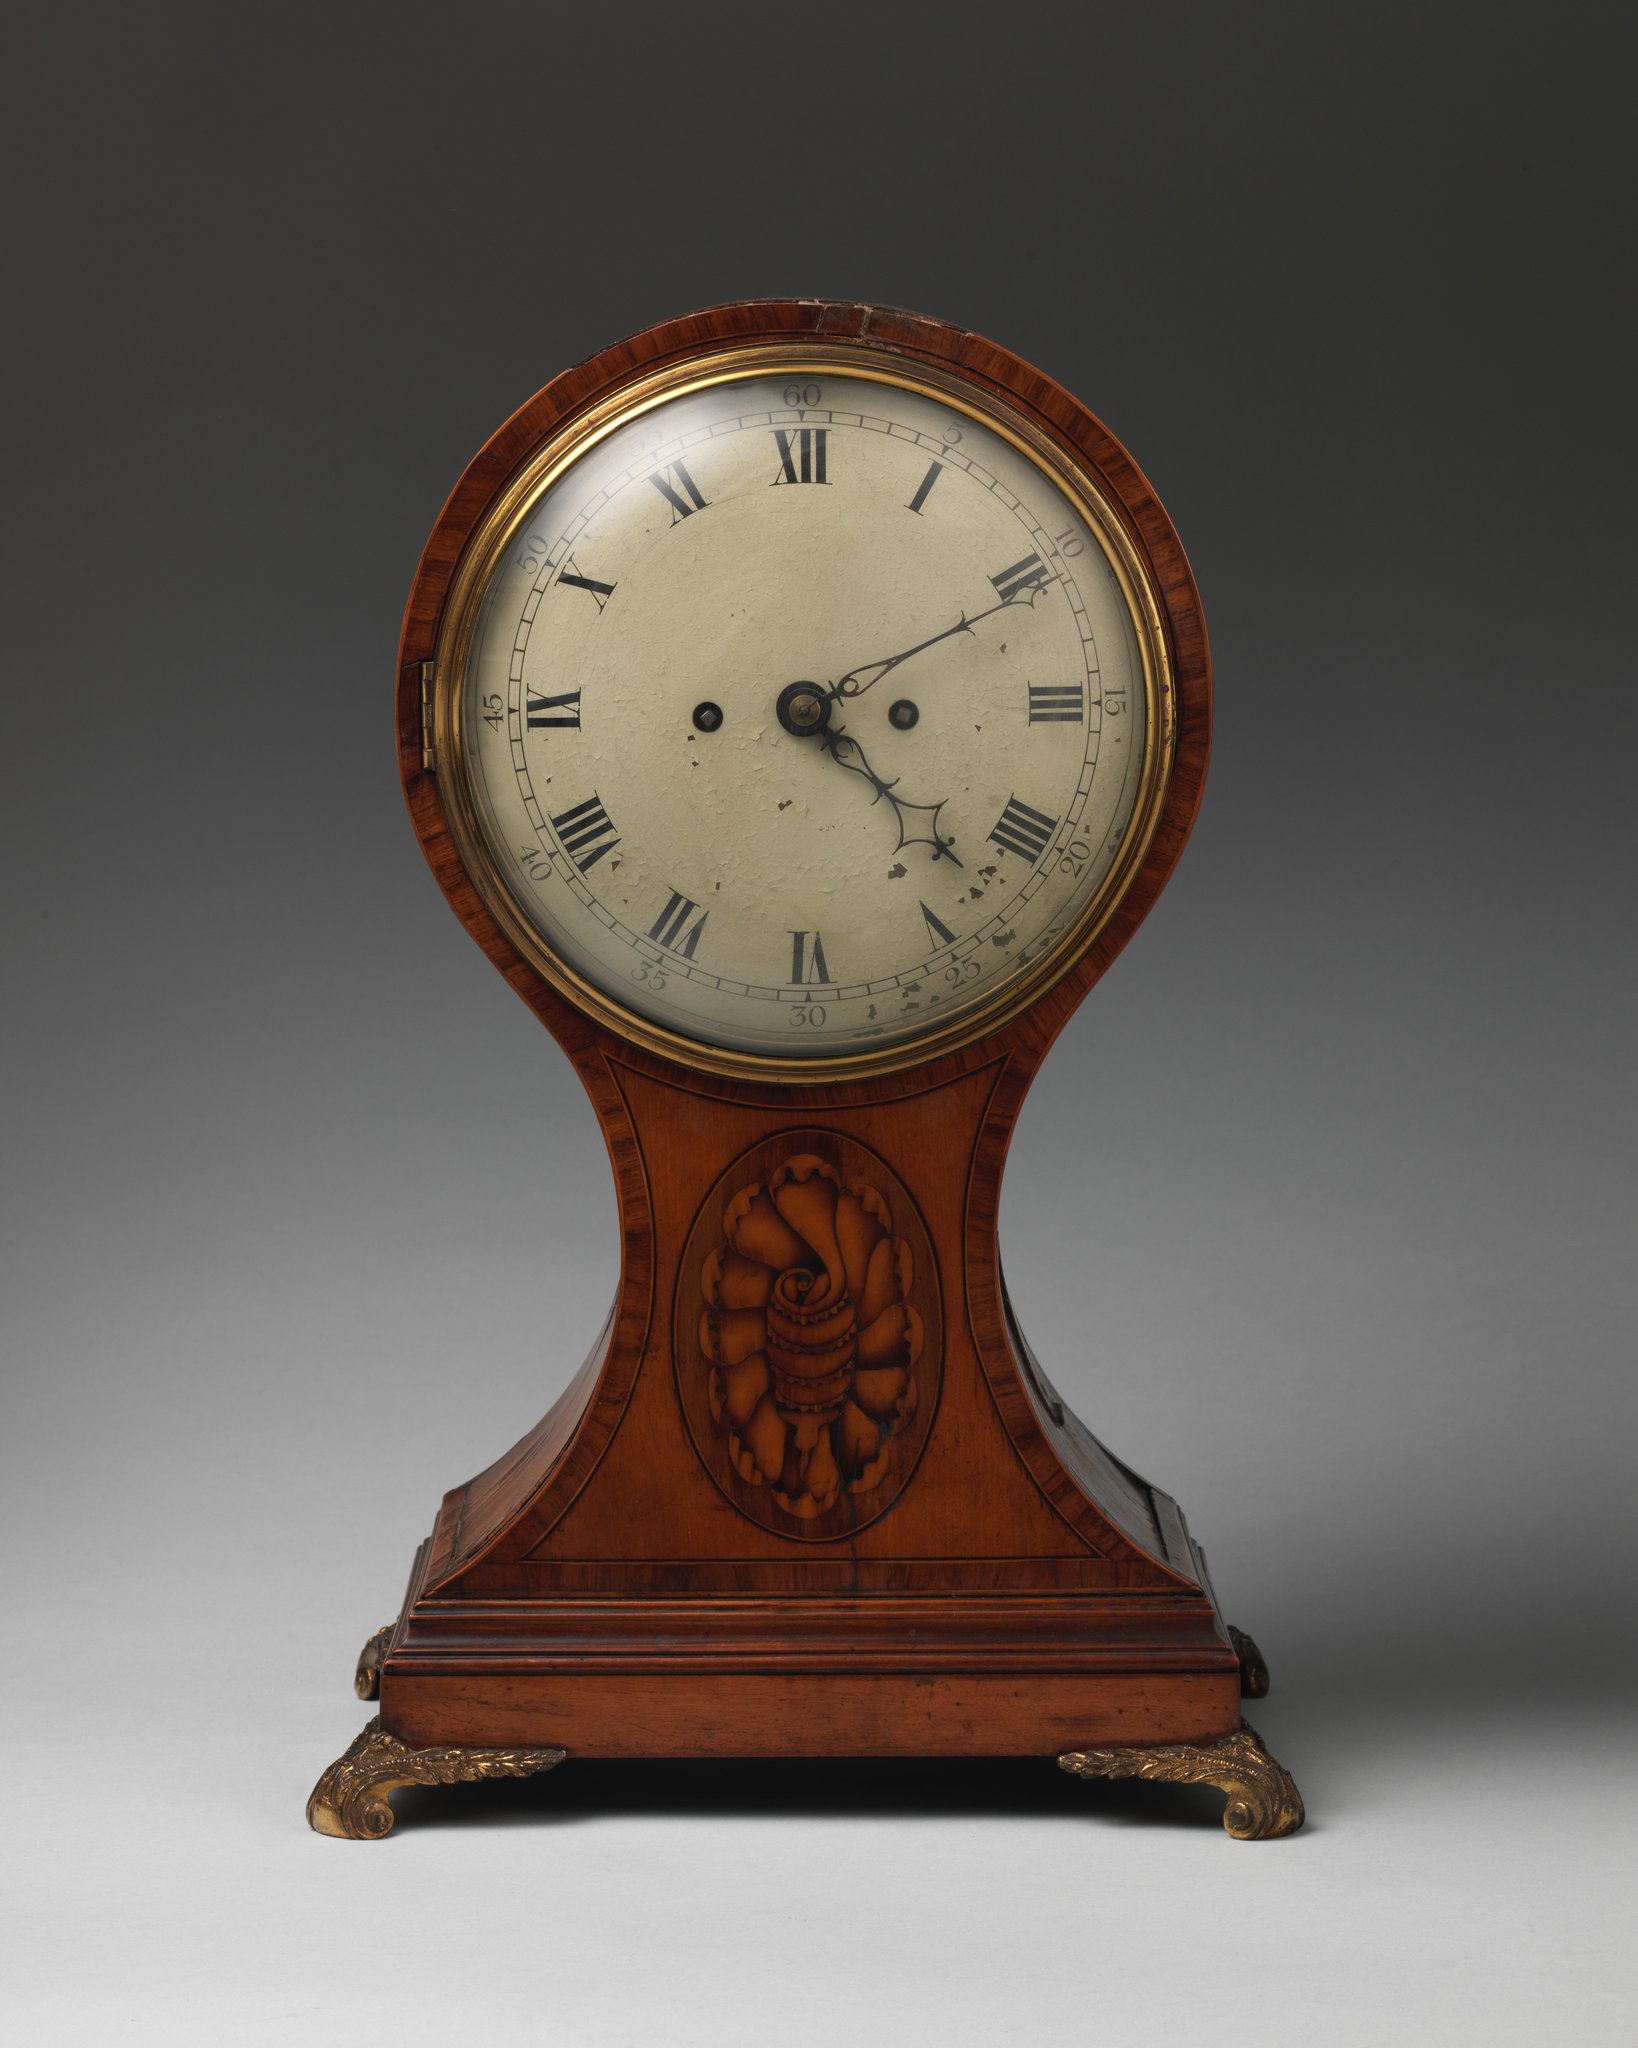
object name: bracket clock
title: Balloon bracket clock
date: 1795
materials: gilt bronze, wood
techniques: inlay, veneering